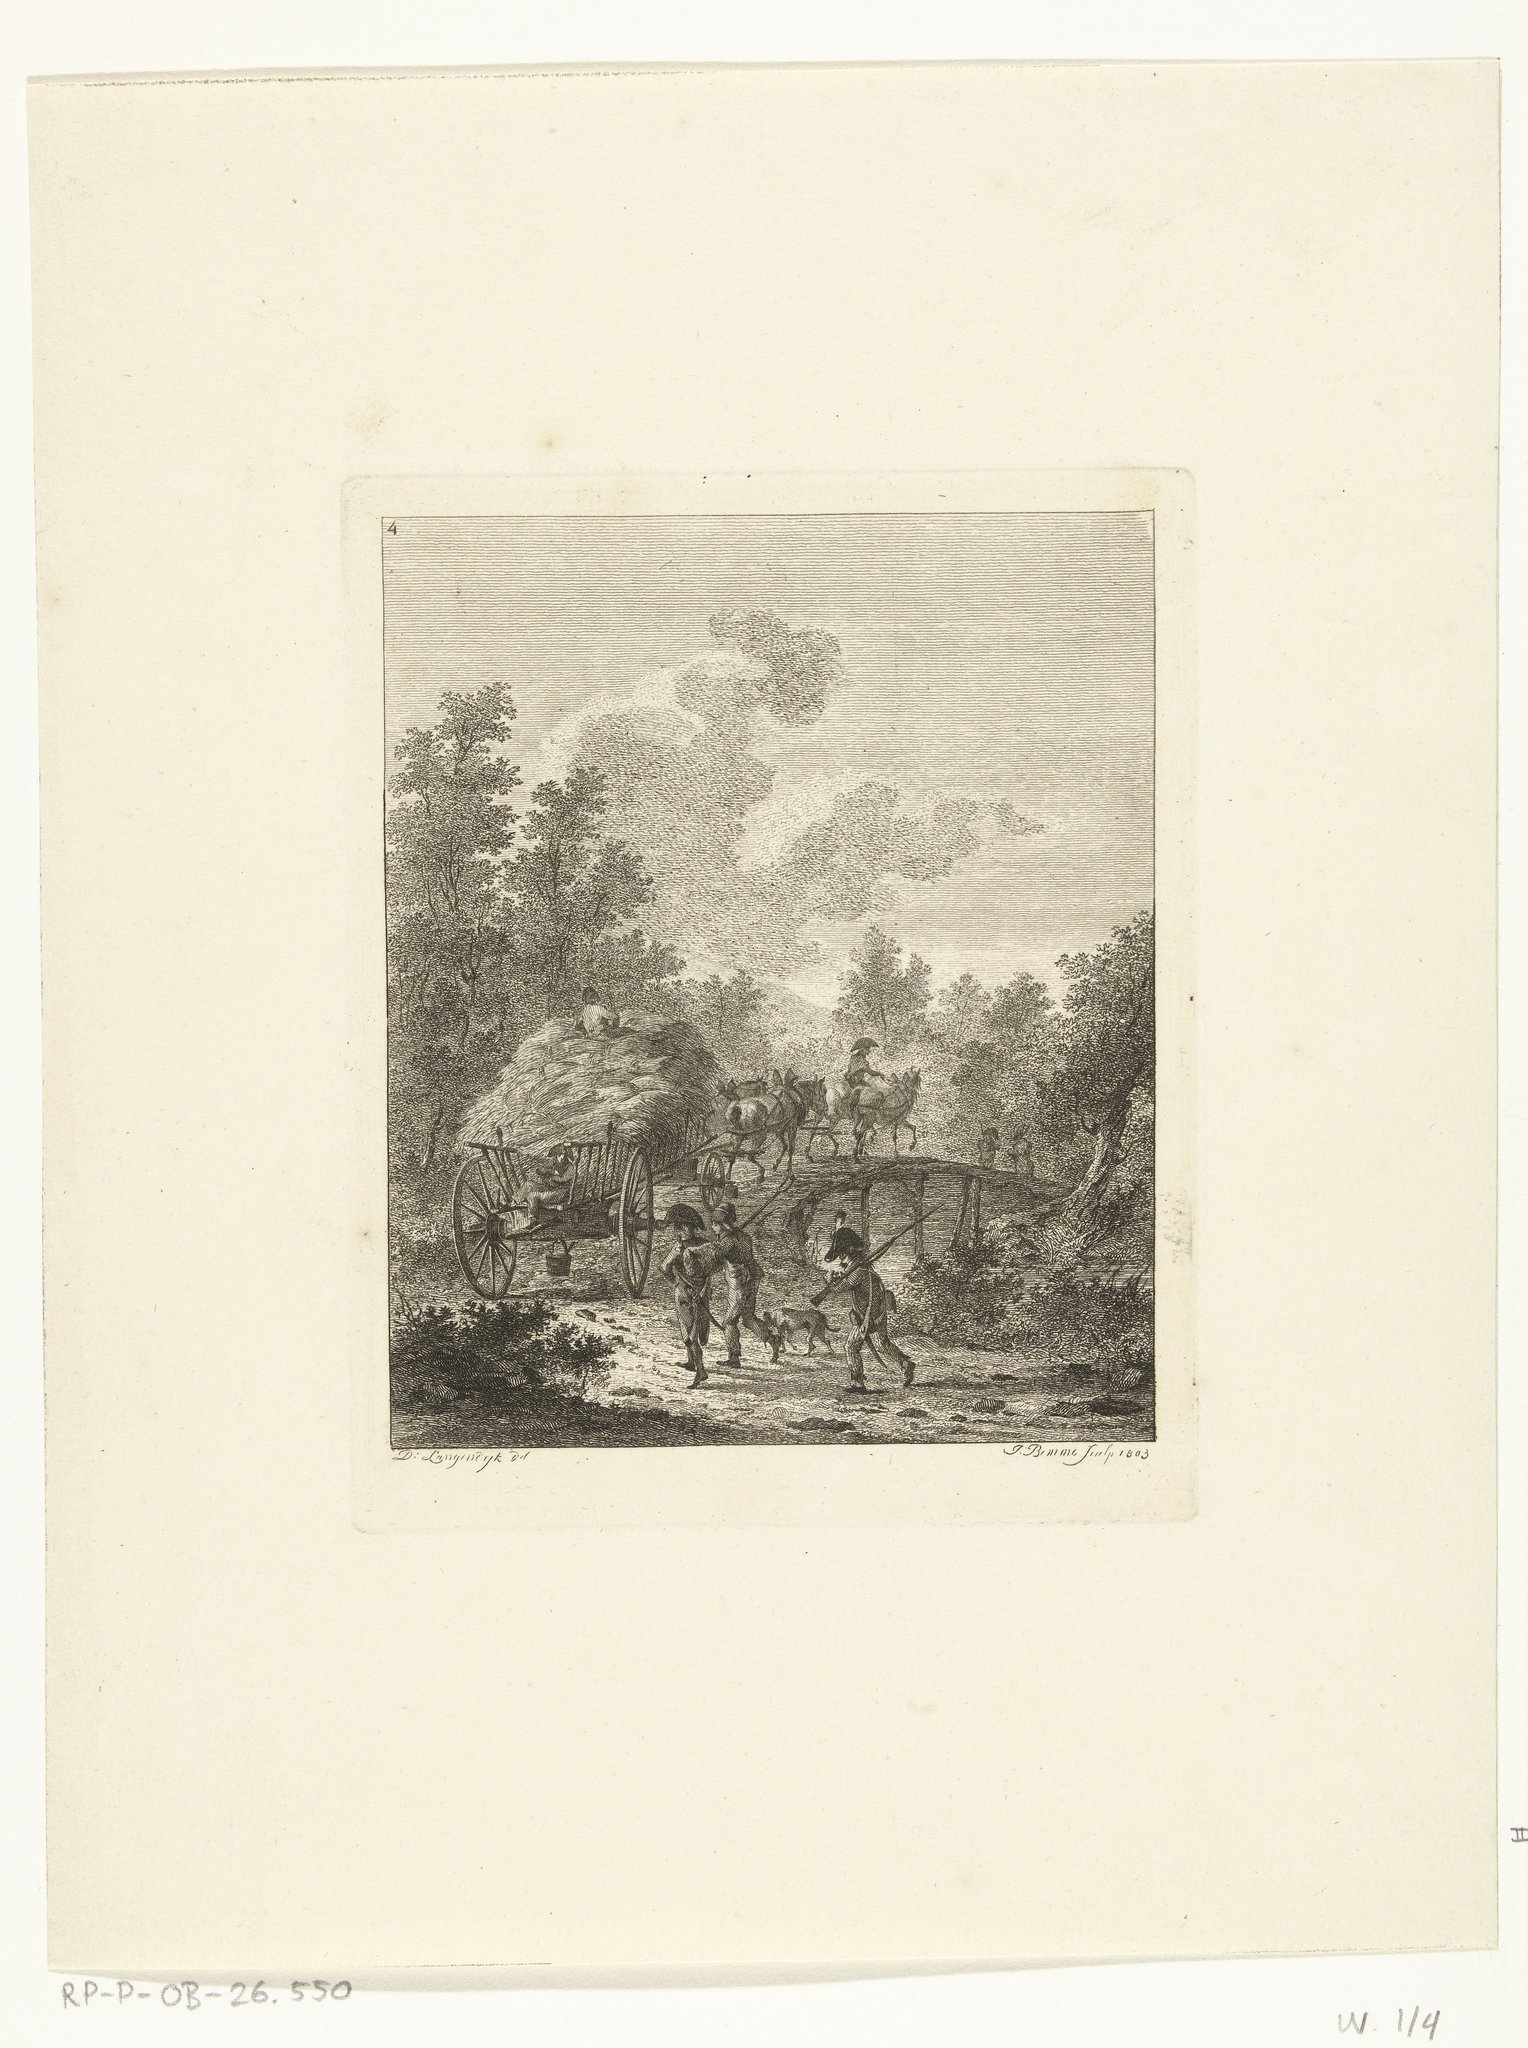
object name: print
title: Zes landschappen met soldatenstaffage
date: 1803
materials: paper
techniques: etching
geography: netherlands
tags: the soldier; the soldier's life, hay-wagon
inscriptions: date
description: Een hooiwagen rijdt over een brug. Langs de oever lopen drie Napoleontische soldaten met geweren en een hond.